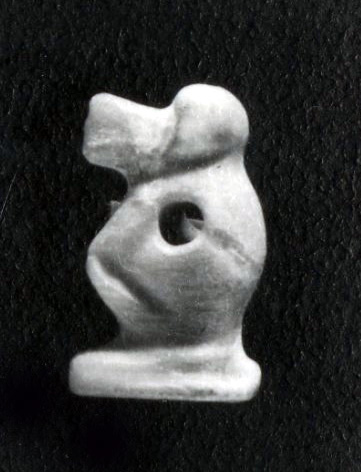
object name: amulet, thoth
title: Thoth amulet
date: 2110-2030 BCE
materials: ivory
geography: egypt